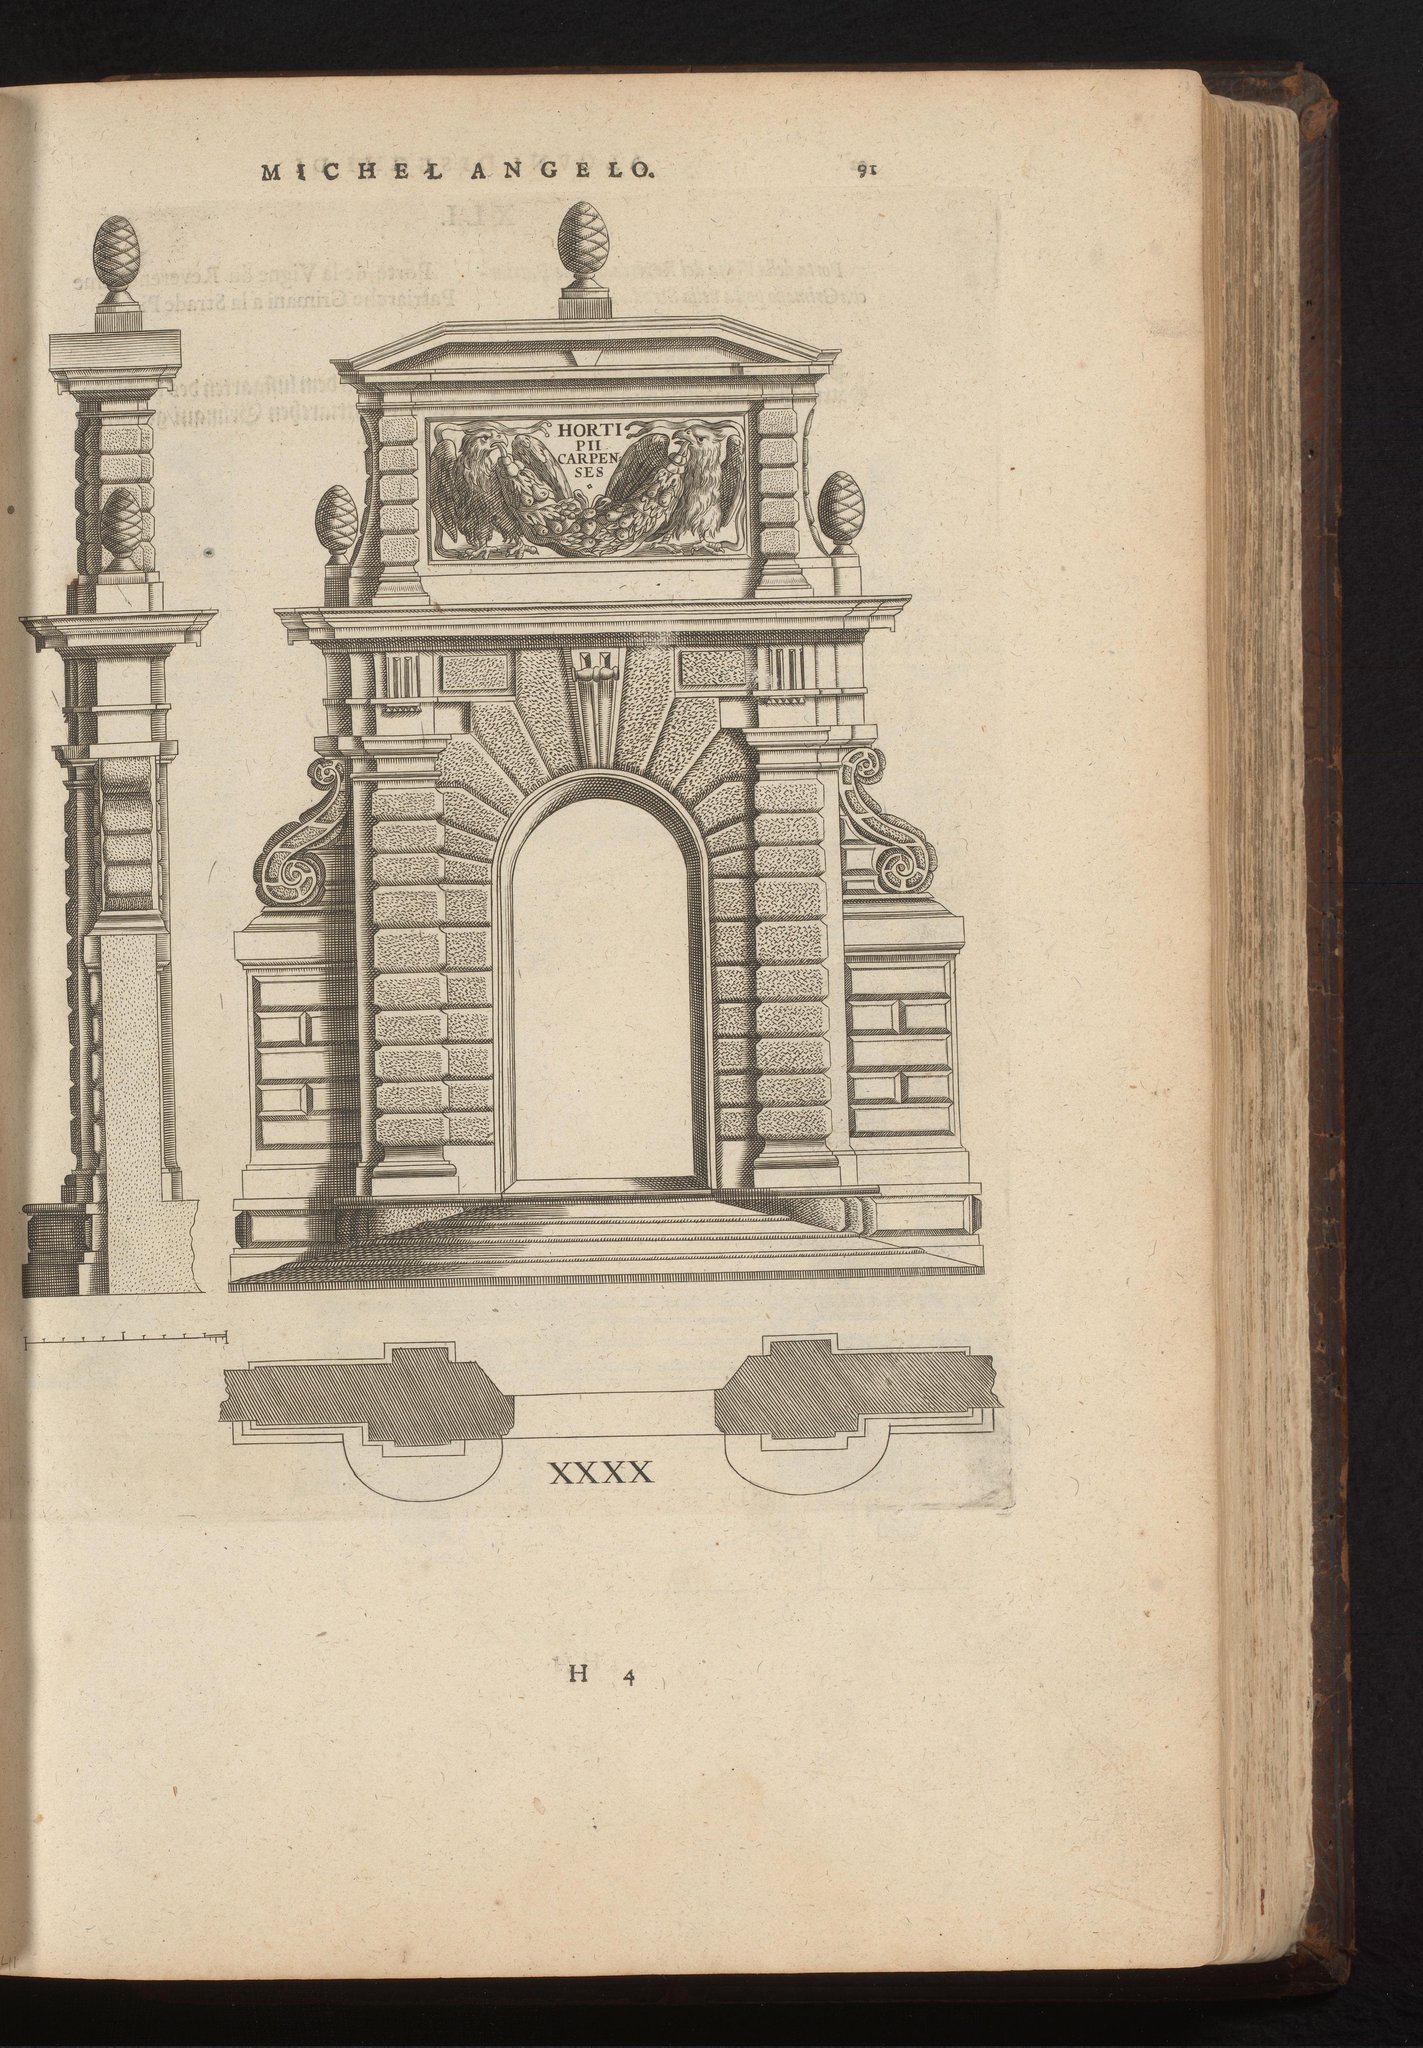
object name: print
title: Poort van de tuin van hertog Sforza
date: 1640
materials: paper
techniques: engraving, letterpress printing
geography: amsterdam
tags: gate, entrance, architecture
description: Prent uit: Vignola, Giacomo Barozzi da. Regola delli cinque ordini d'architettura (...). Amsterdam: Johannes Willemszoon en Cornelis Blaeu, 1640, p. 91.